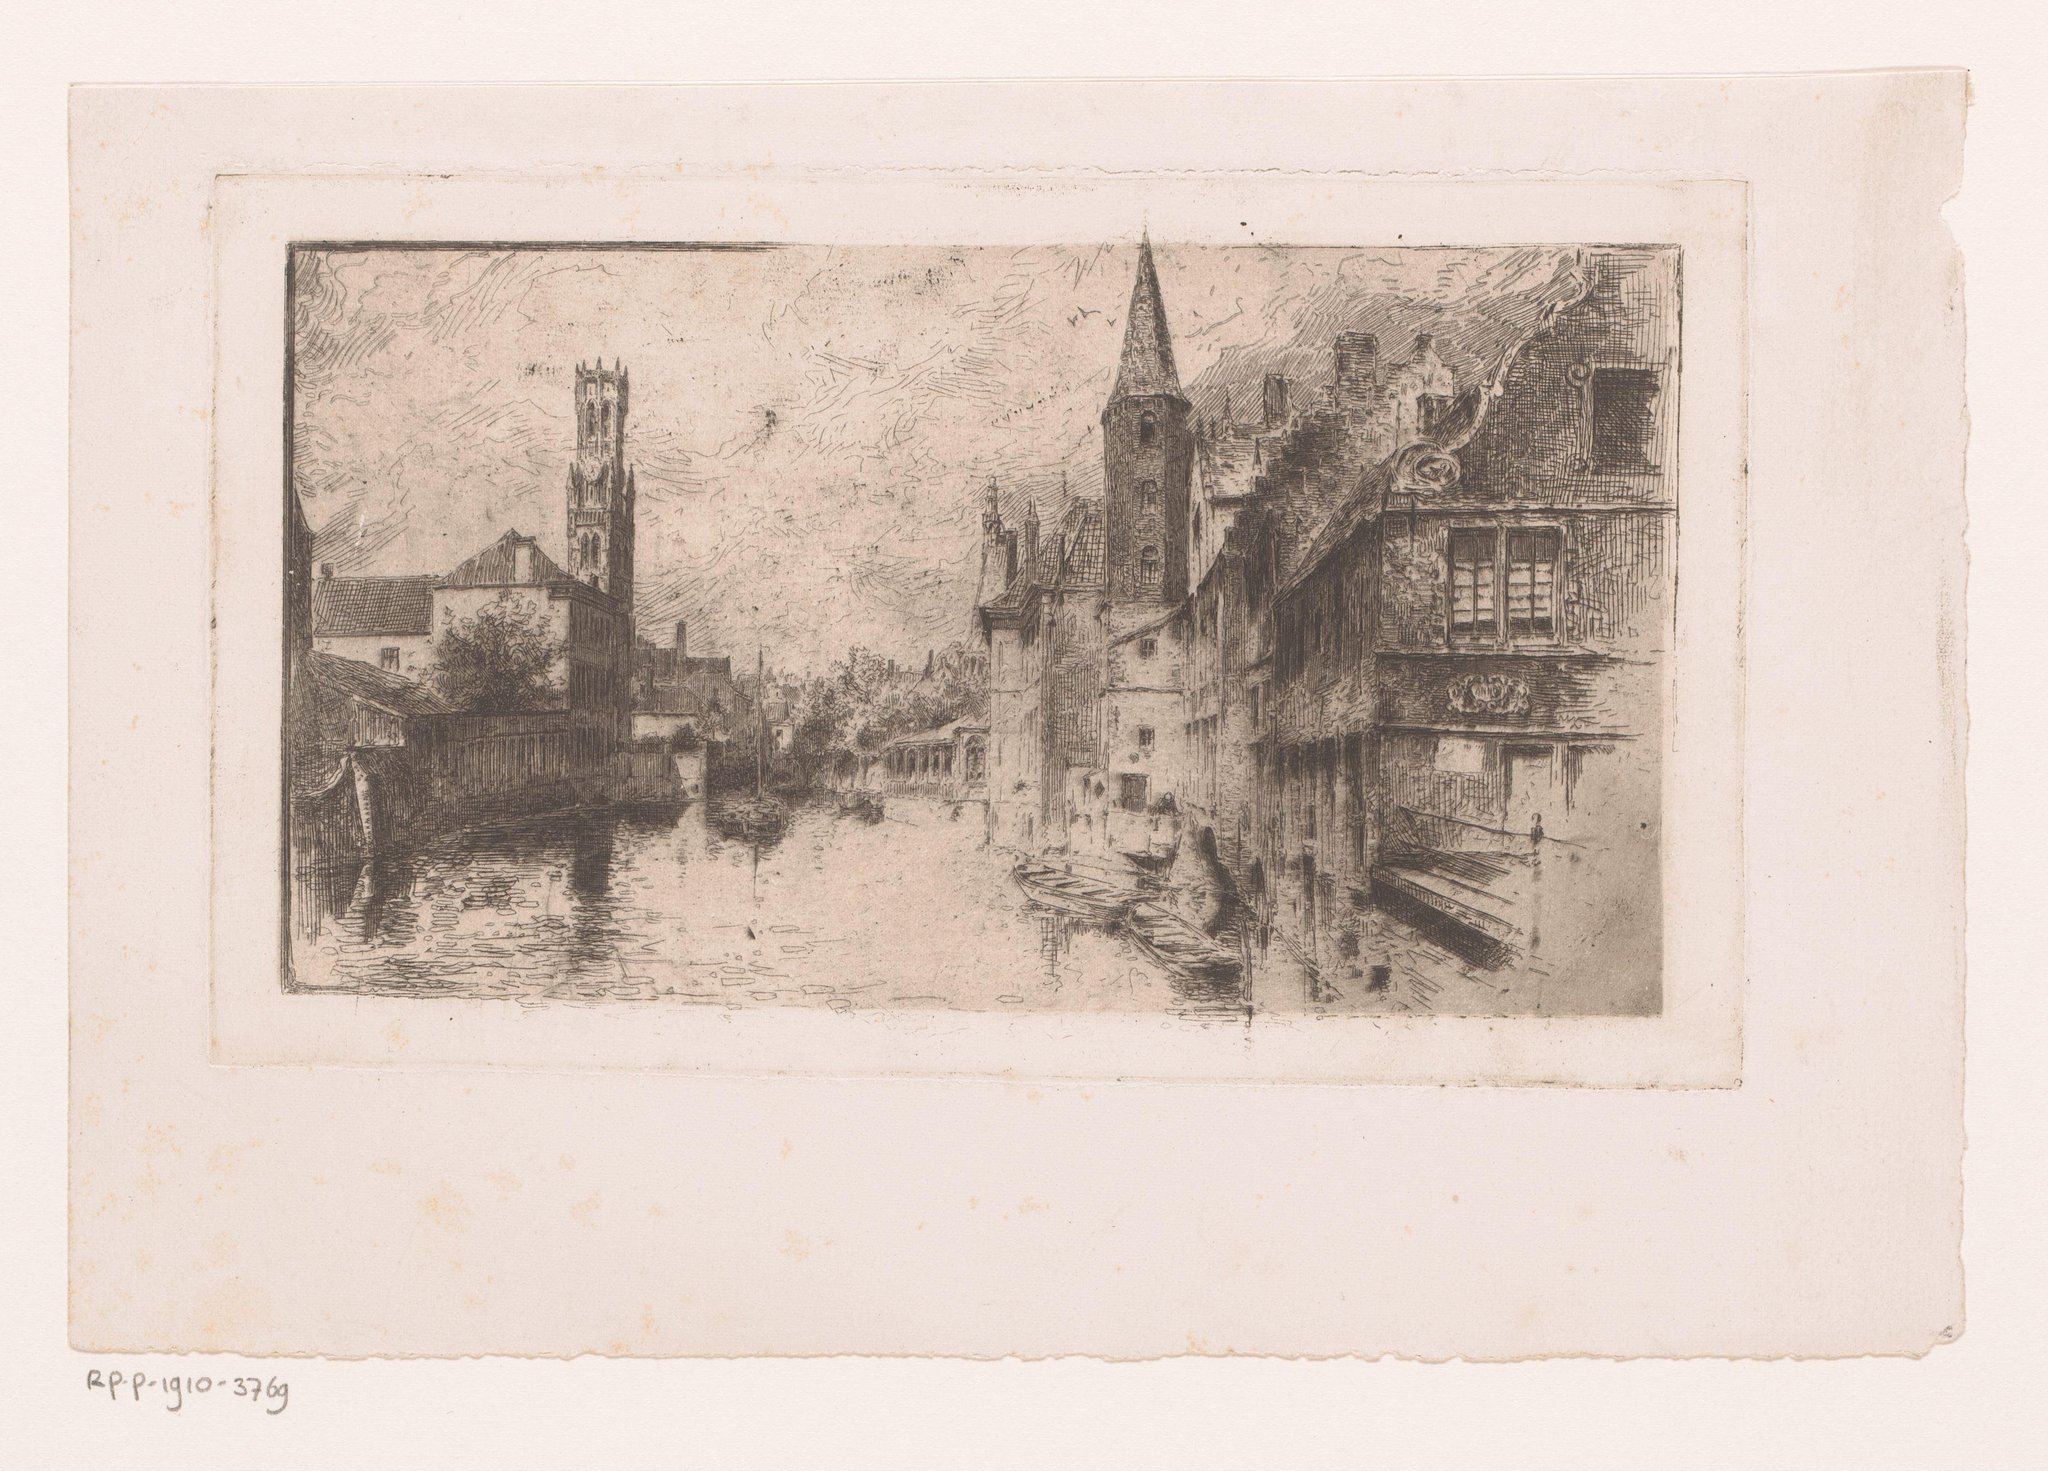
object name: print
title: Stadsgezicht met gracht en toren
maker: armand heins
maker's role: print maker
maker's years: 1856-1938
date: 1866-1910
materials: paper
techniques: etching, intaglio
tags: city-view in general; 'veduta', canals, waters (in city)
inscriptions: collector's mark: Lugt 2228